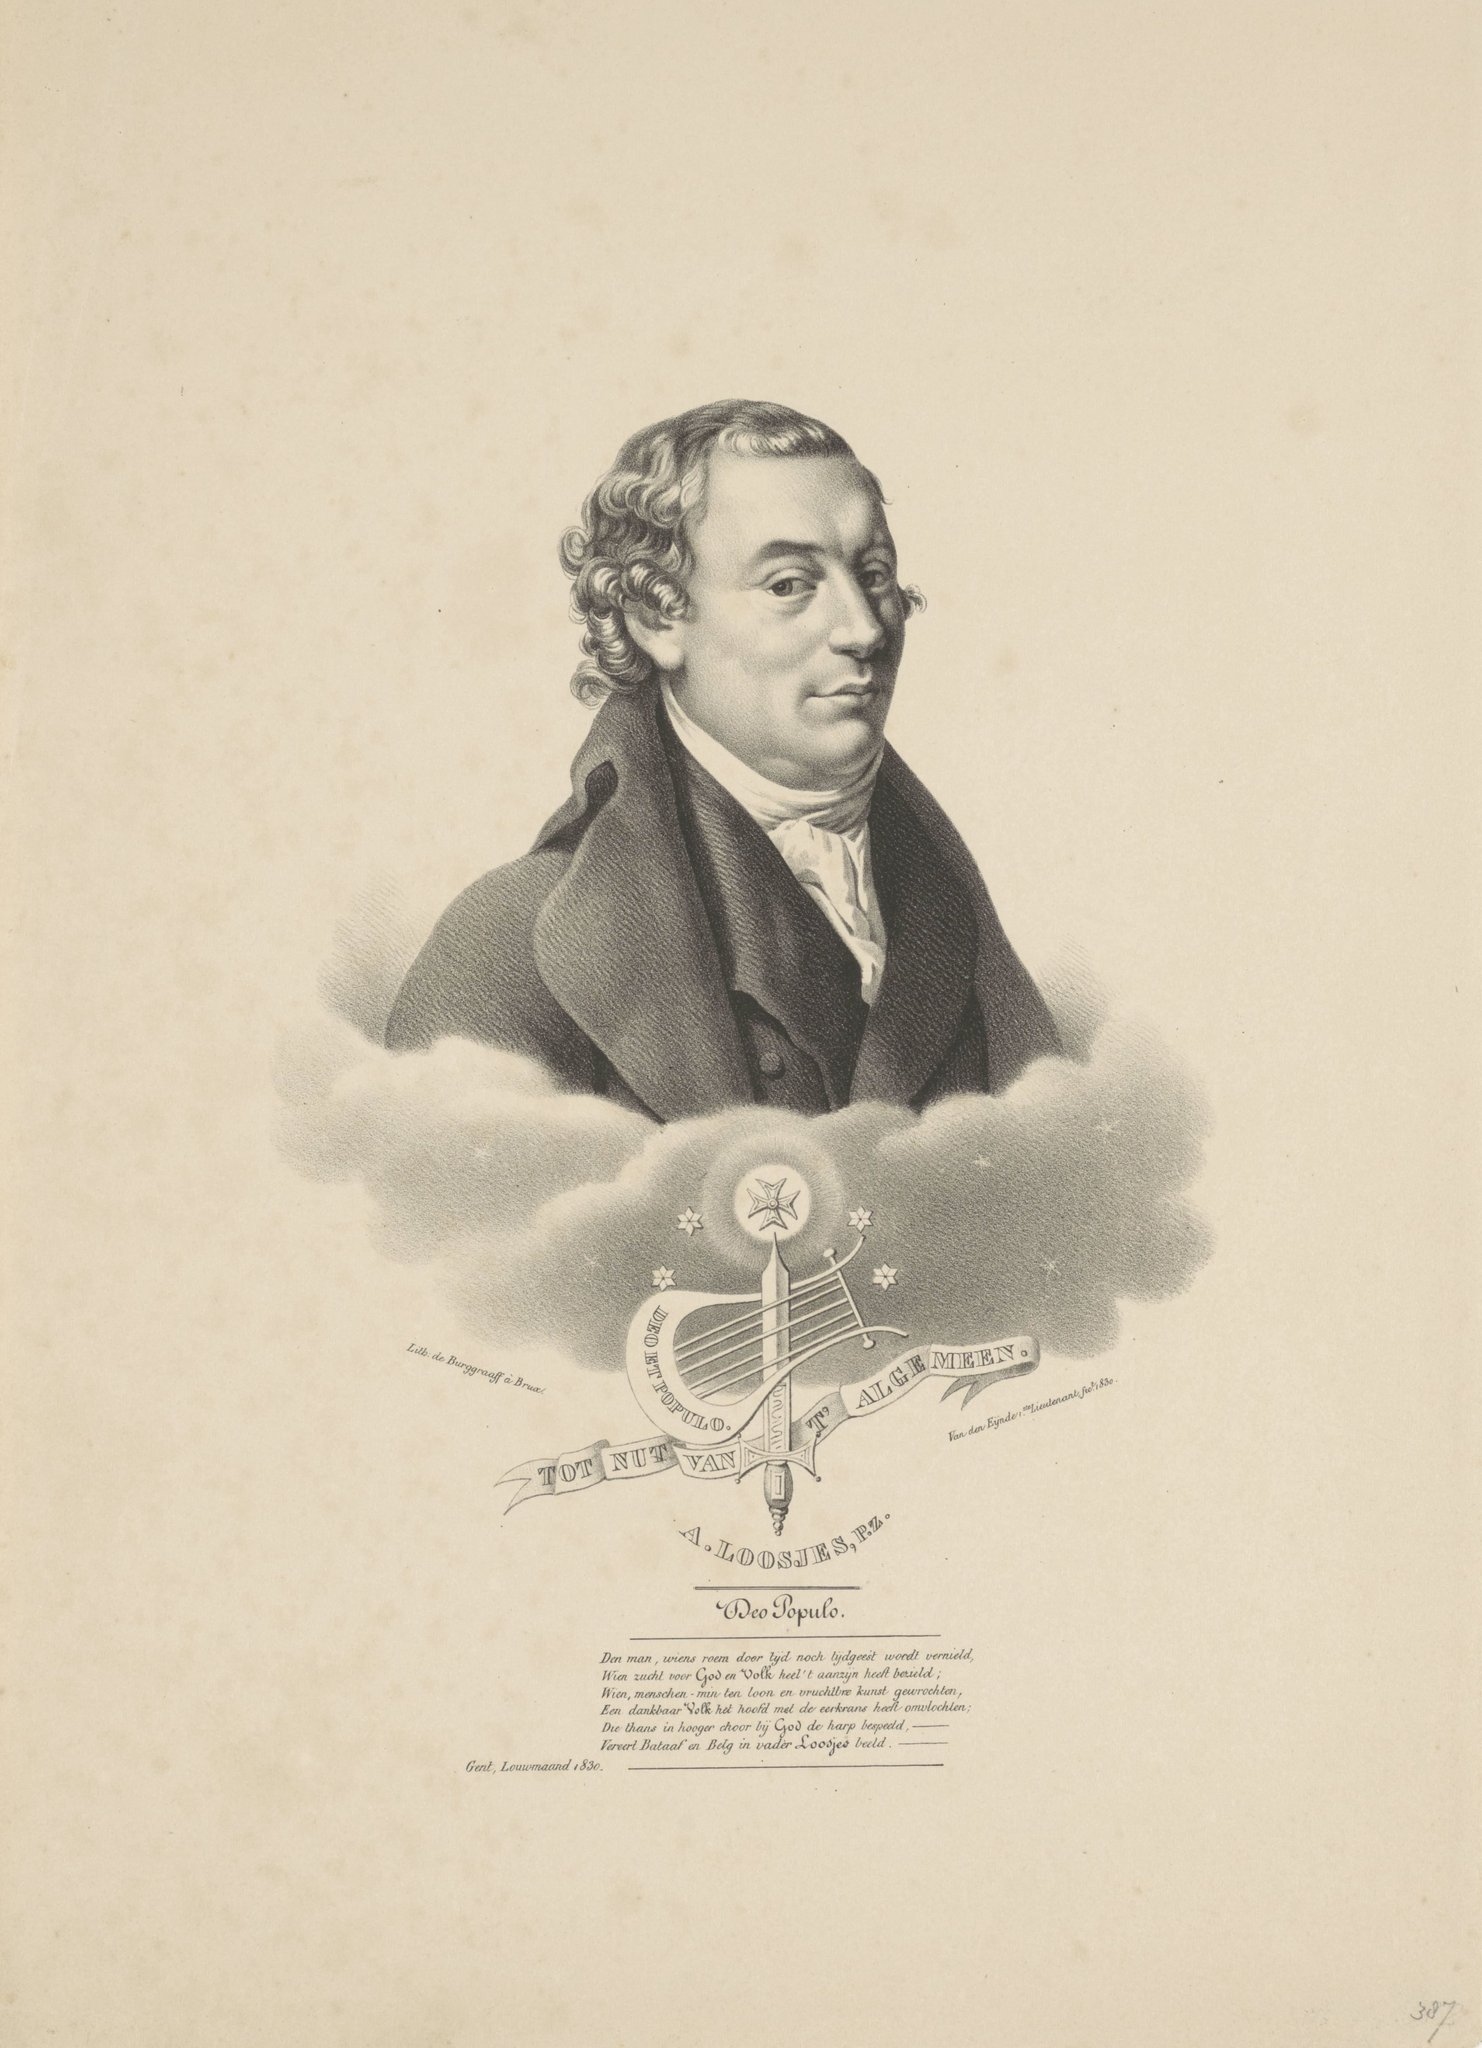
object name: print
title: Portret van Adriaan Pietersz. Loosjes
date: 1830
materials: paper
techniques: lithograph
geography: brussels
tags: haarlem, publisher, bookseller, adriaan pietersz. loosjes, hacking and thrusting weapons: sword, harp, historical persons (+ (full) bust portrait)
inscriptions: collector's mark: Lugt 2228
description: De geportretteerde is in een wolkenpartij met sterren afgebeeld. Hij is naar rechts gewend. Onder het portret een zwaard met een kruis, een harp met de woorden 'Deo et Populo' en een lint met de woorden: 'Tot nut van 't Algemeen.' Daaronder de naam van de geportretteerde en een zesregelig onderschrift.